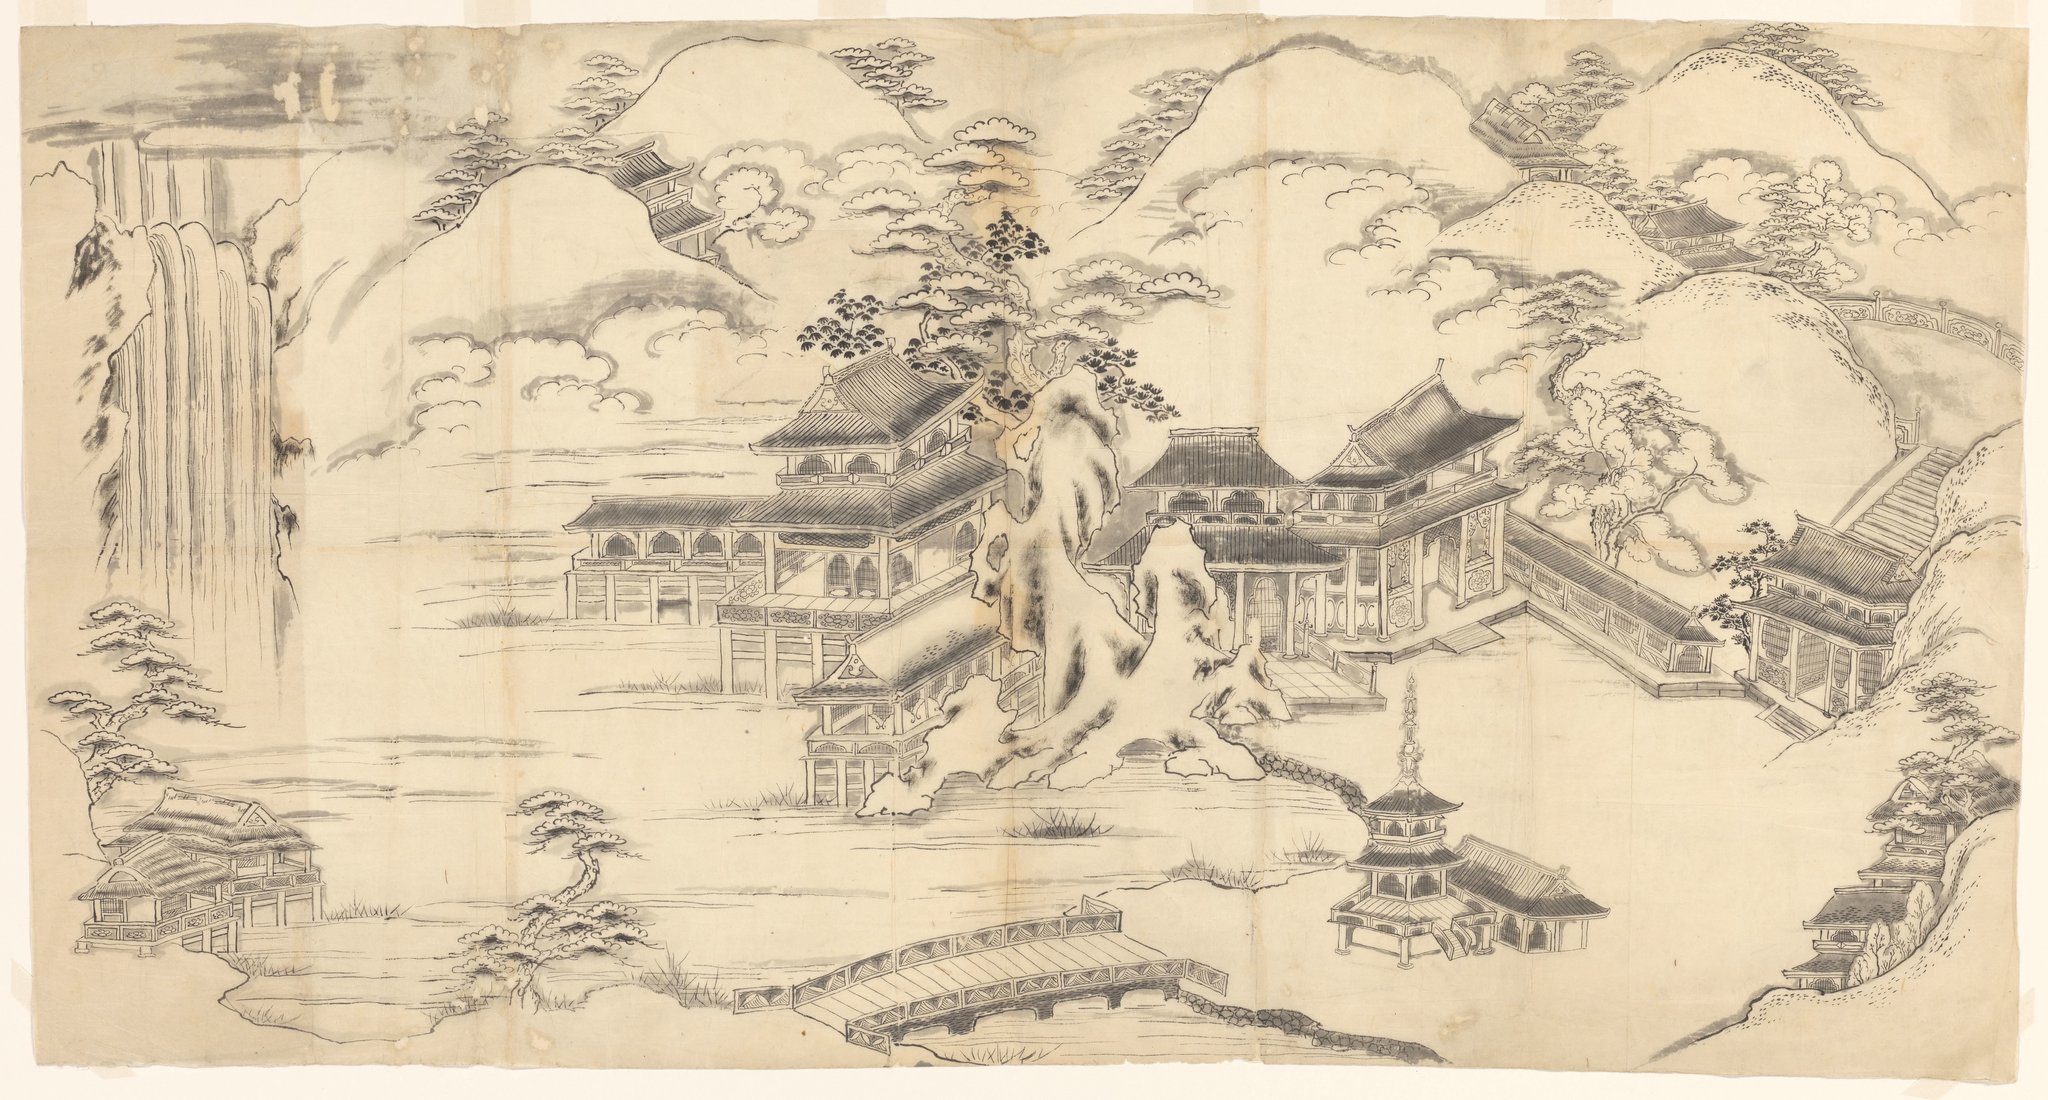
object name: design drawing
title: Landschap in Chinese stijl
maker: sasaya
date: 1800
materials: ink, paint, paper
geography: kyoto